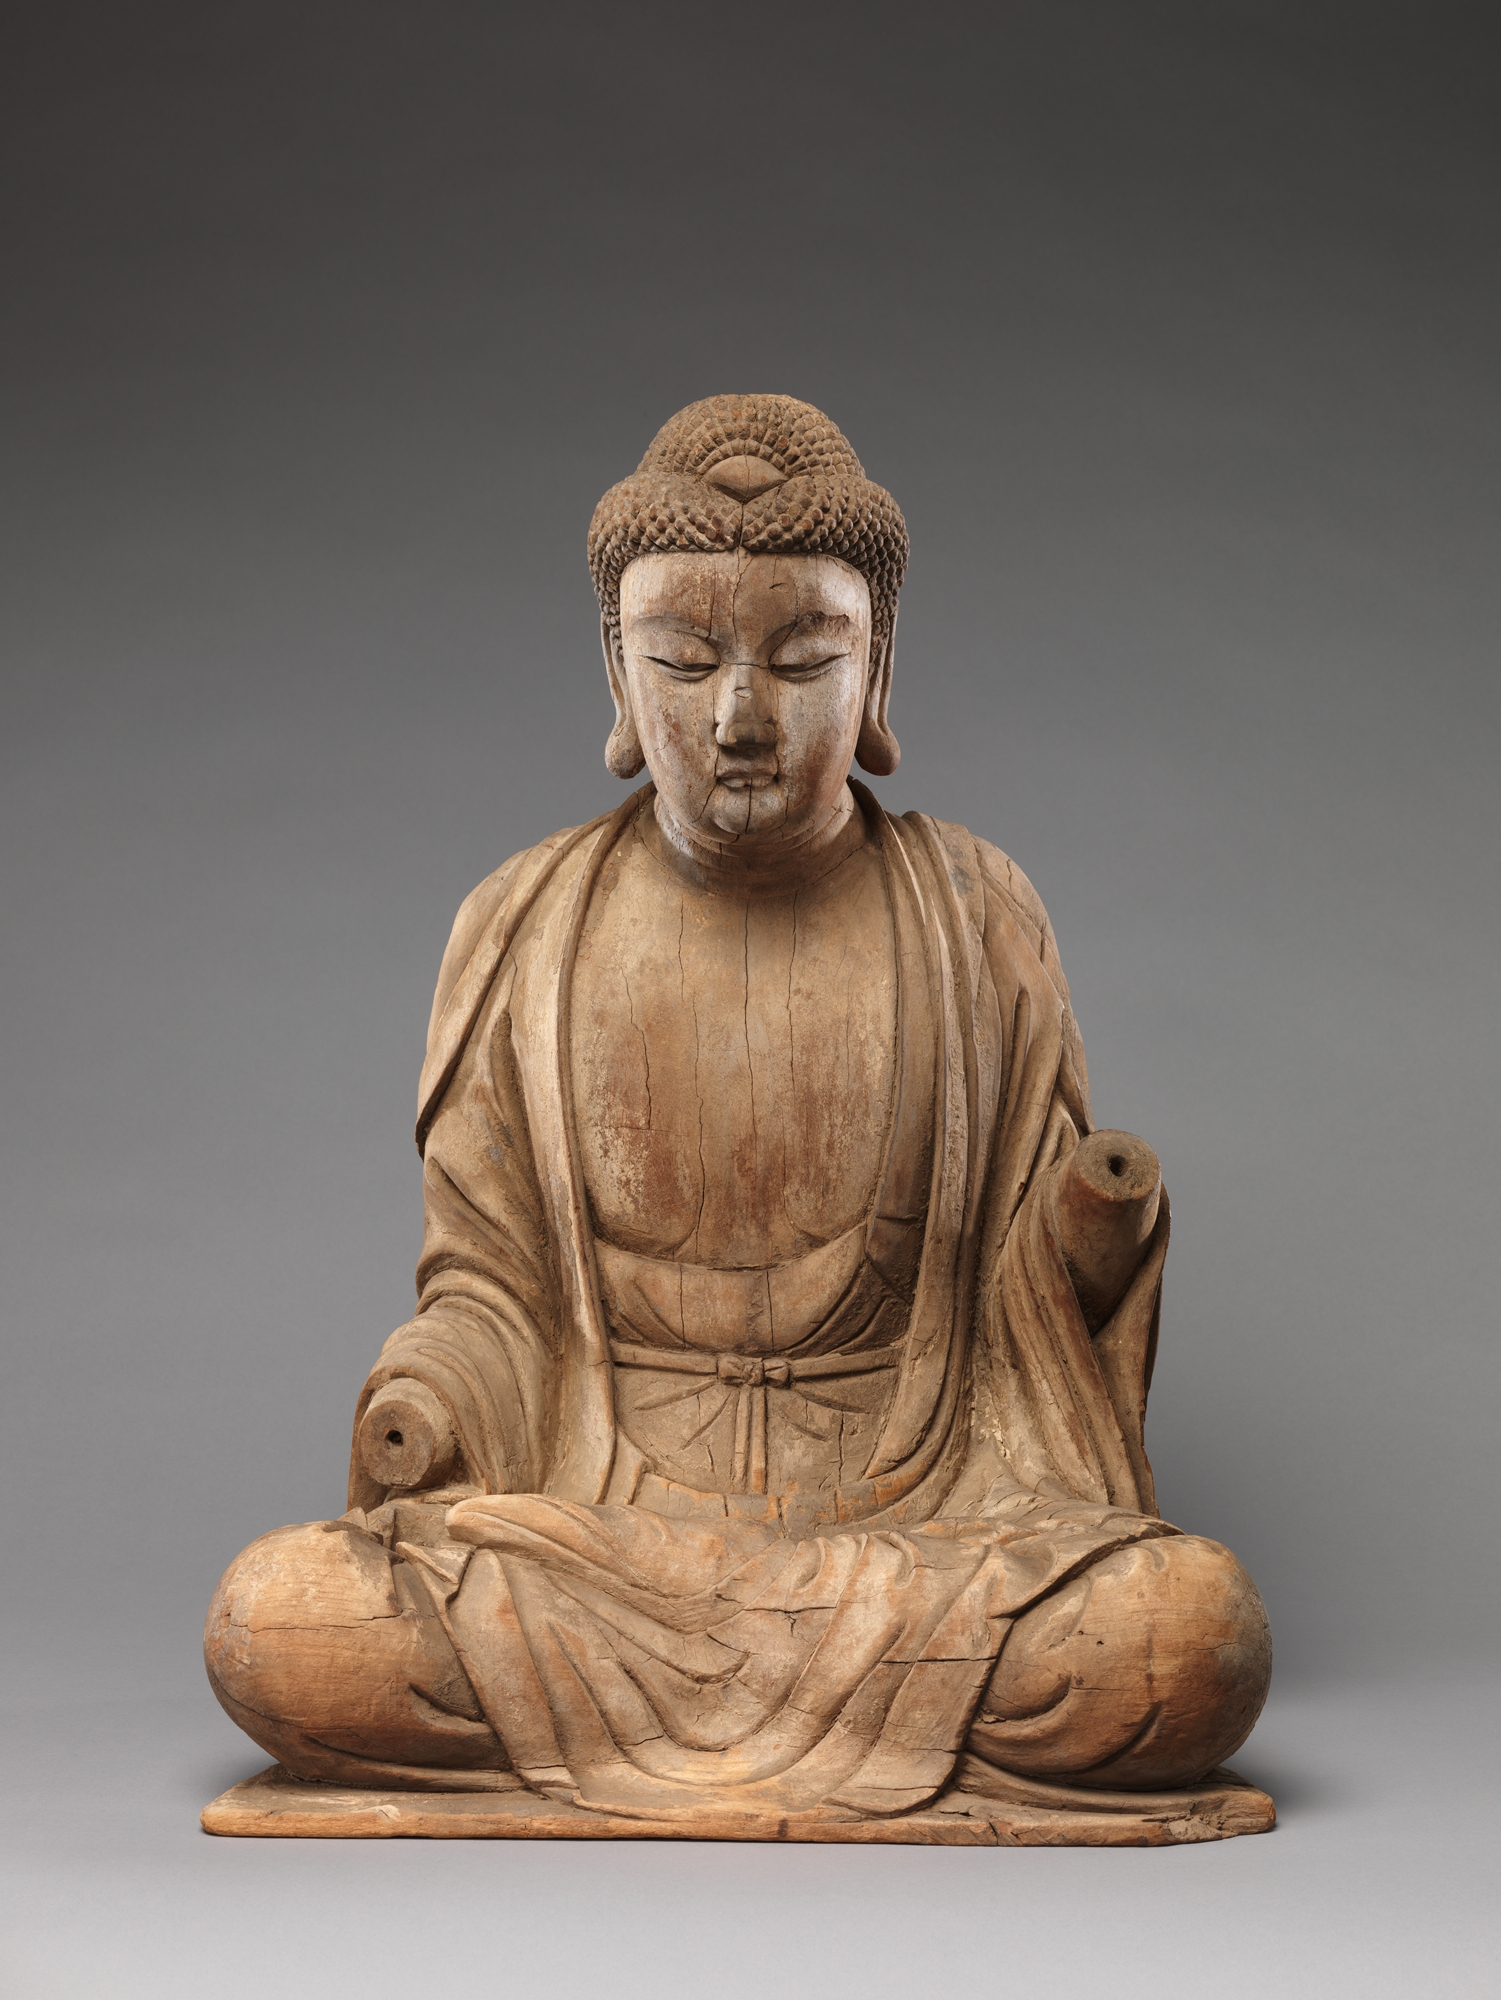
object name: figure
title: Buddha, probably Shakyamuni (Shijiamouni)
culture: chinese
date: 1101-1300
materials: pigment, wood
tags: buddhism,buddha,shakyamuni